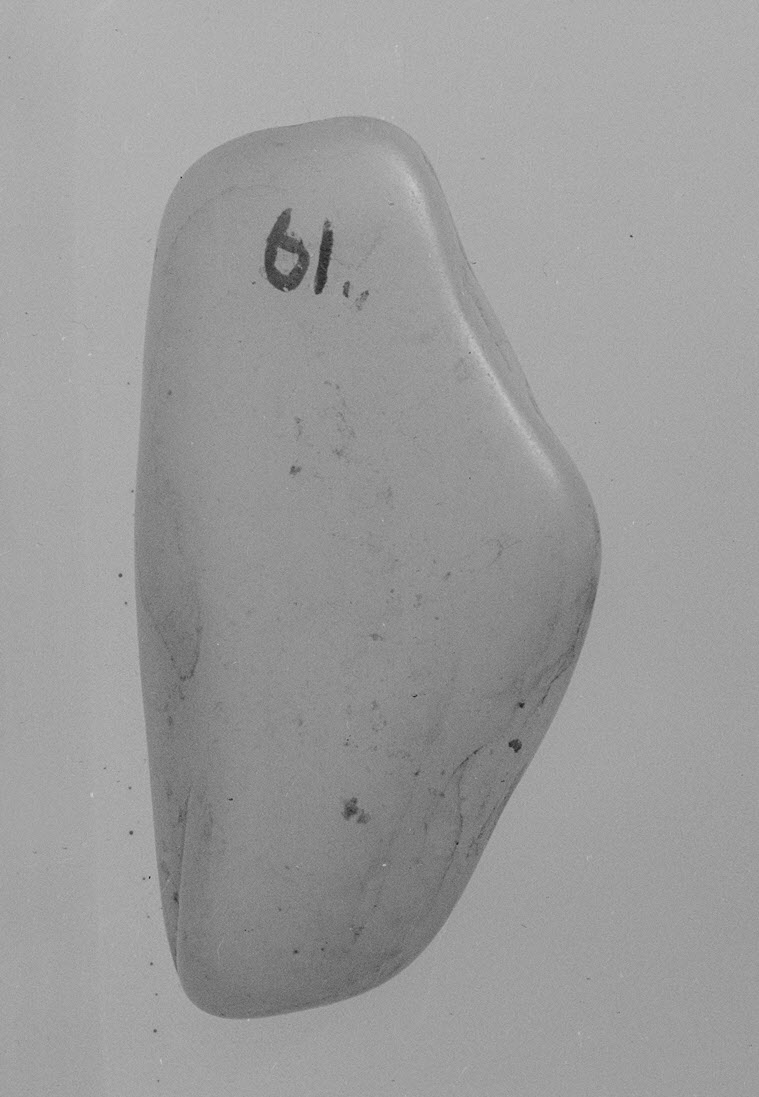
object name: pebble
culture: chinese or turkestani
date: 1902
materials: jade